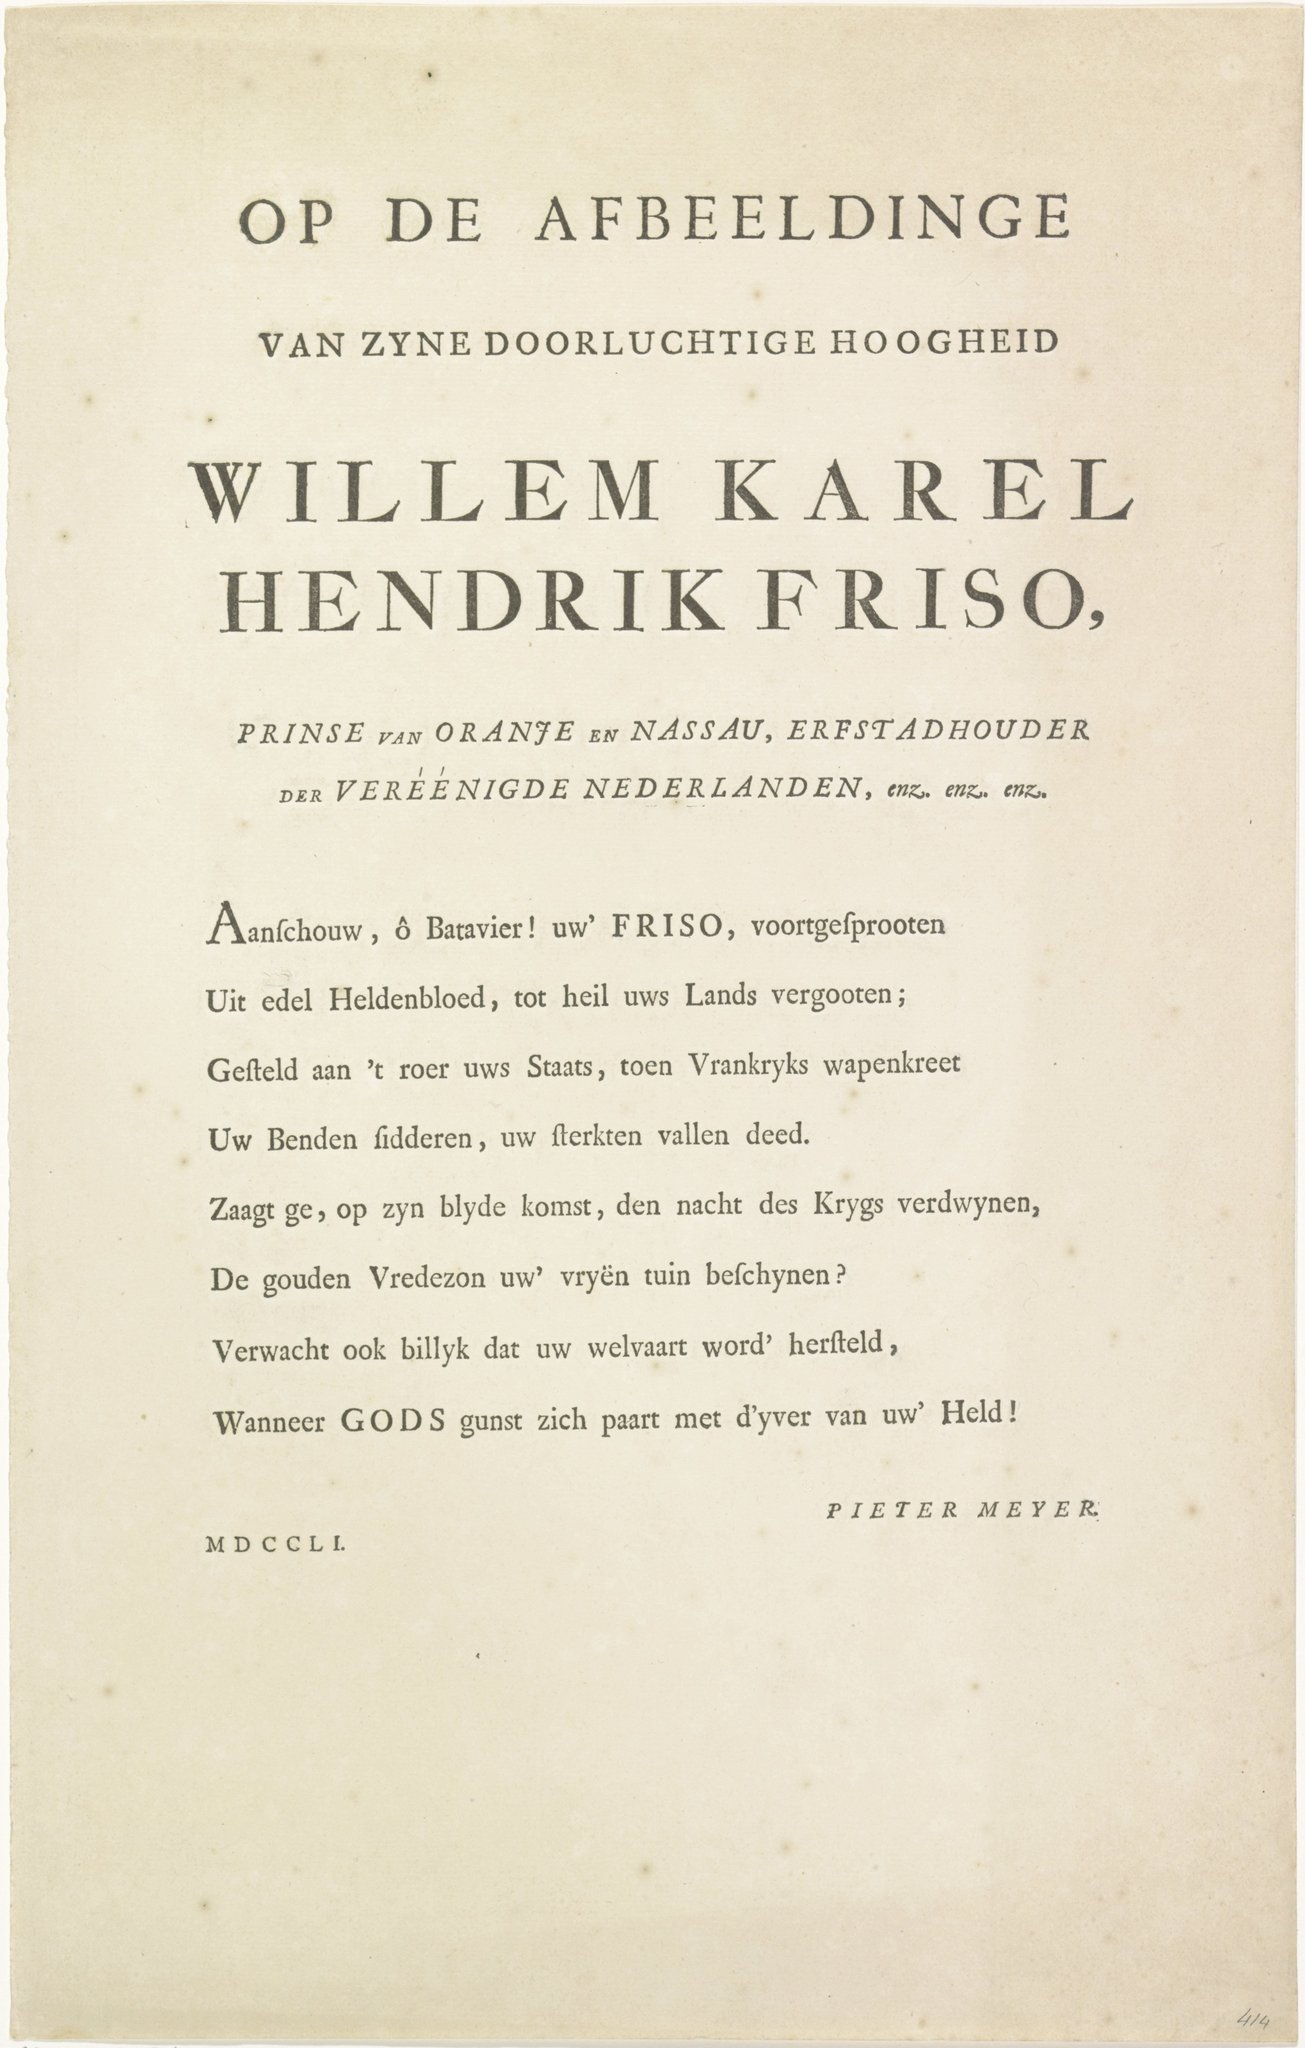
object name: text sheet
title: Tekst bij het portret van Willem IV, prins van Oranje-Nassau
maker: pieter meyer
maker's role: publisher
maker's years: 1718-1781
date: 1751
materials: paper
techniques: letterpress printing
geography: amsterdam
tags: the hague, willem iv (prins van oranje-nassau)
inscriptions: collector's mark: Lugt 2228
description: De hier vermelde titel verwijst naar de hoogst verkregen titel van de geportretteerde, niet per se naar de titel die de geportretteerde op deze voorstelling draagt.